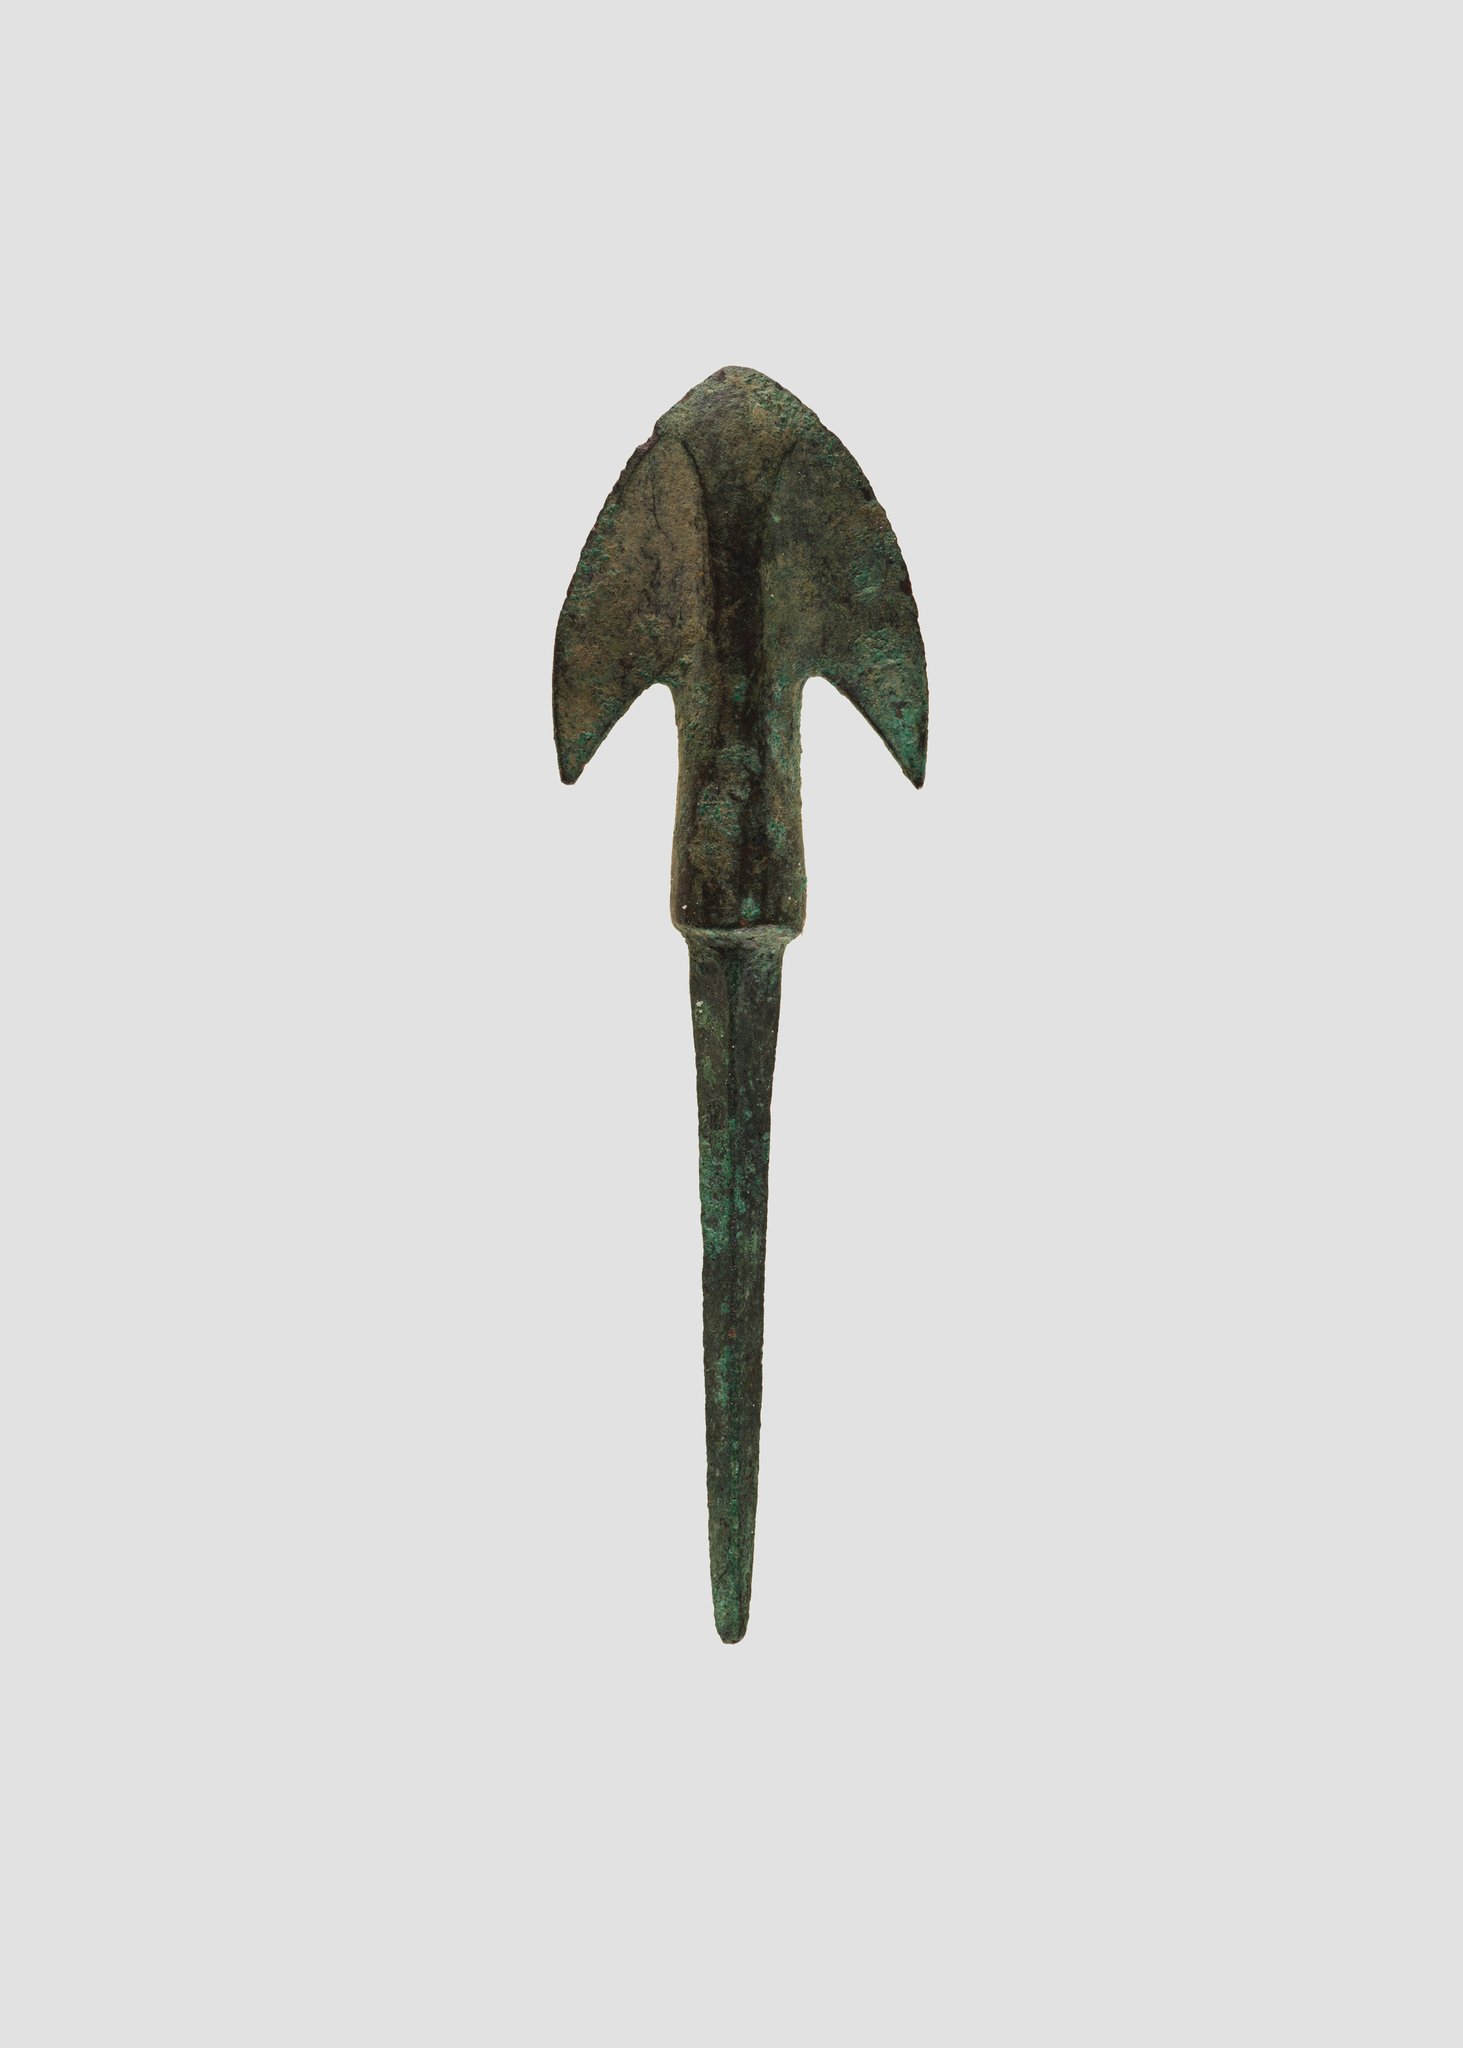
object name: arrowhead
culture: iranian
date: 2000-1 BCE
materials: bronze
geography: iran